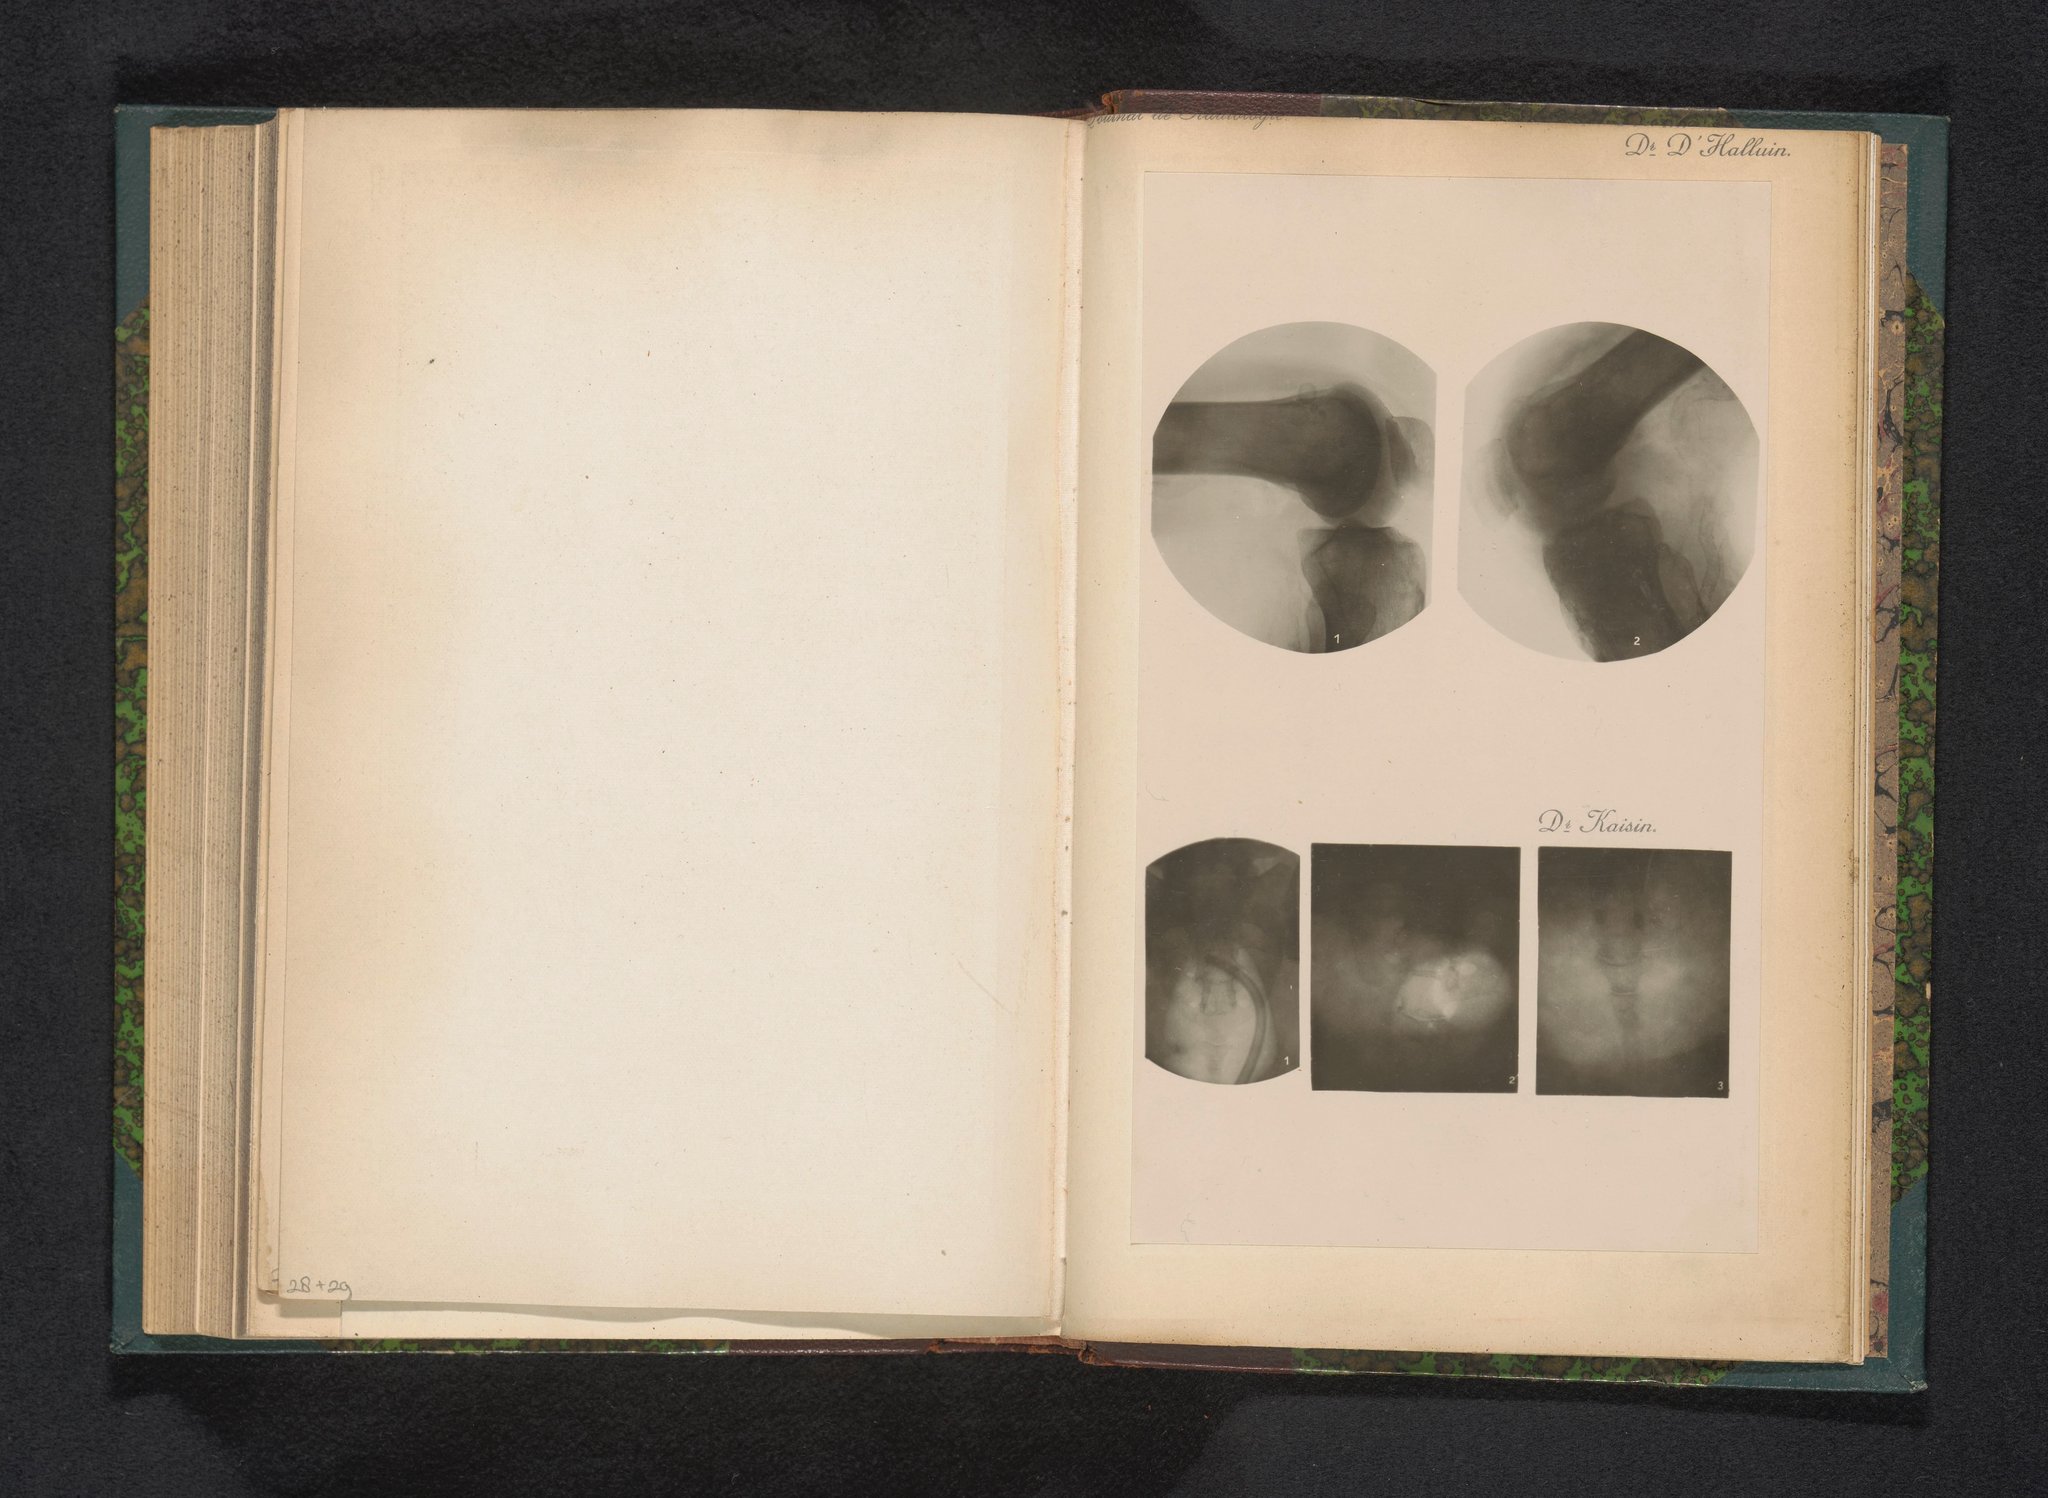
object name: photograph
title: Twee röntgenfoto's van een kniegewricht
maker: Anonymous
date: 1904-1909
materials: photographic support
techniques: gelatin silver print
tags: x-ray examination, bones of the legs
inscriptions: name: ‘Dr. D'Halluin’